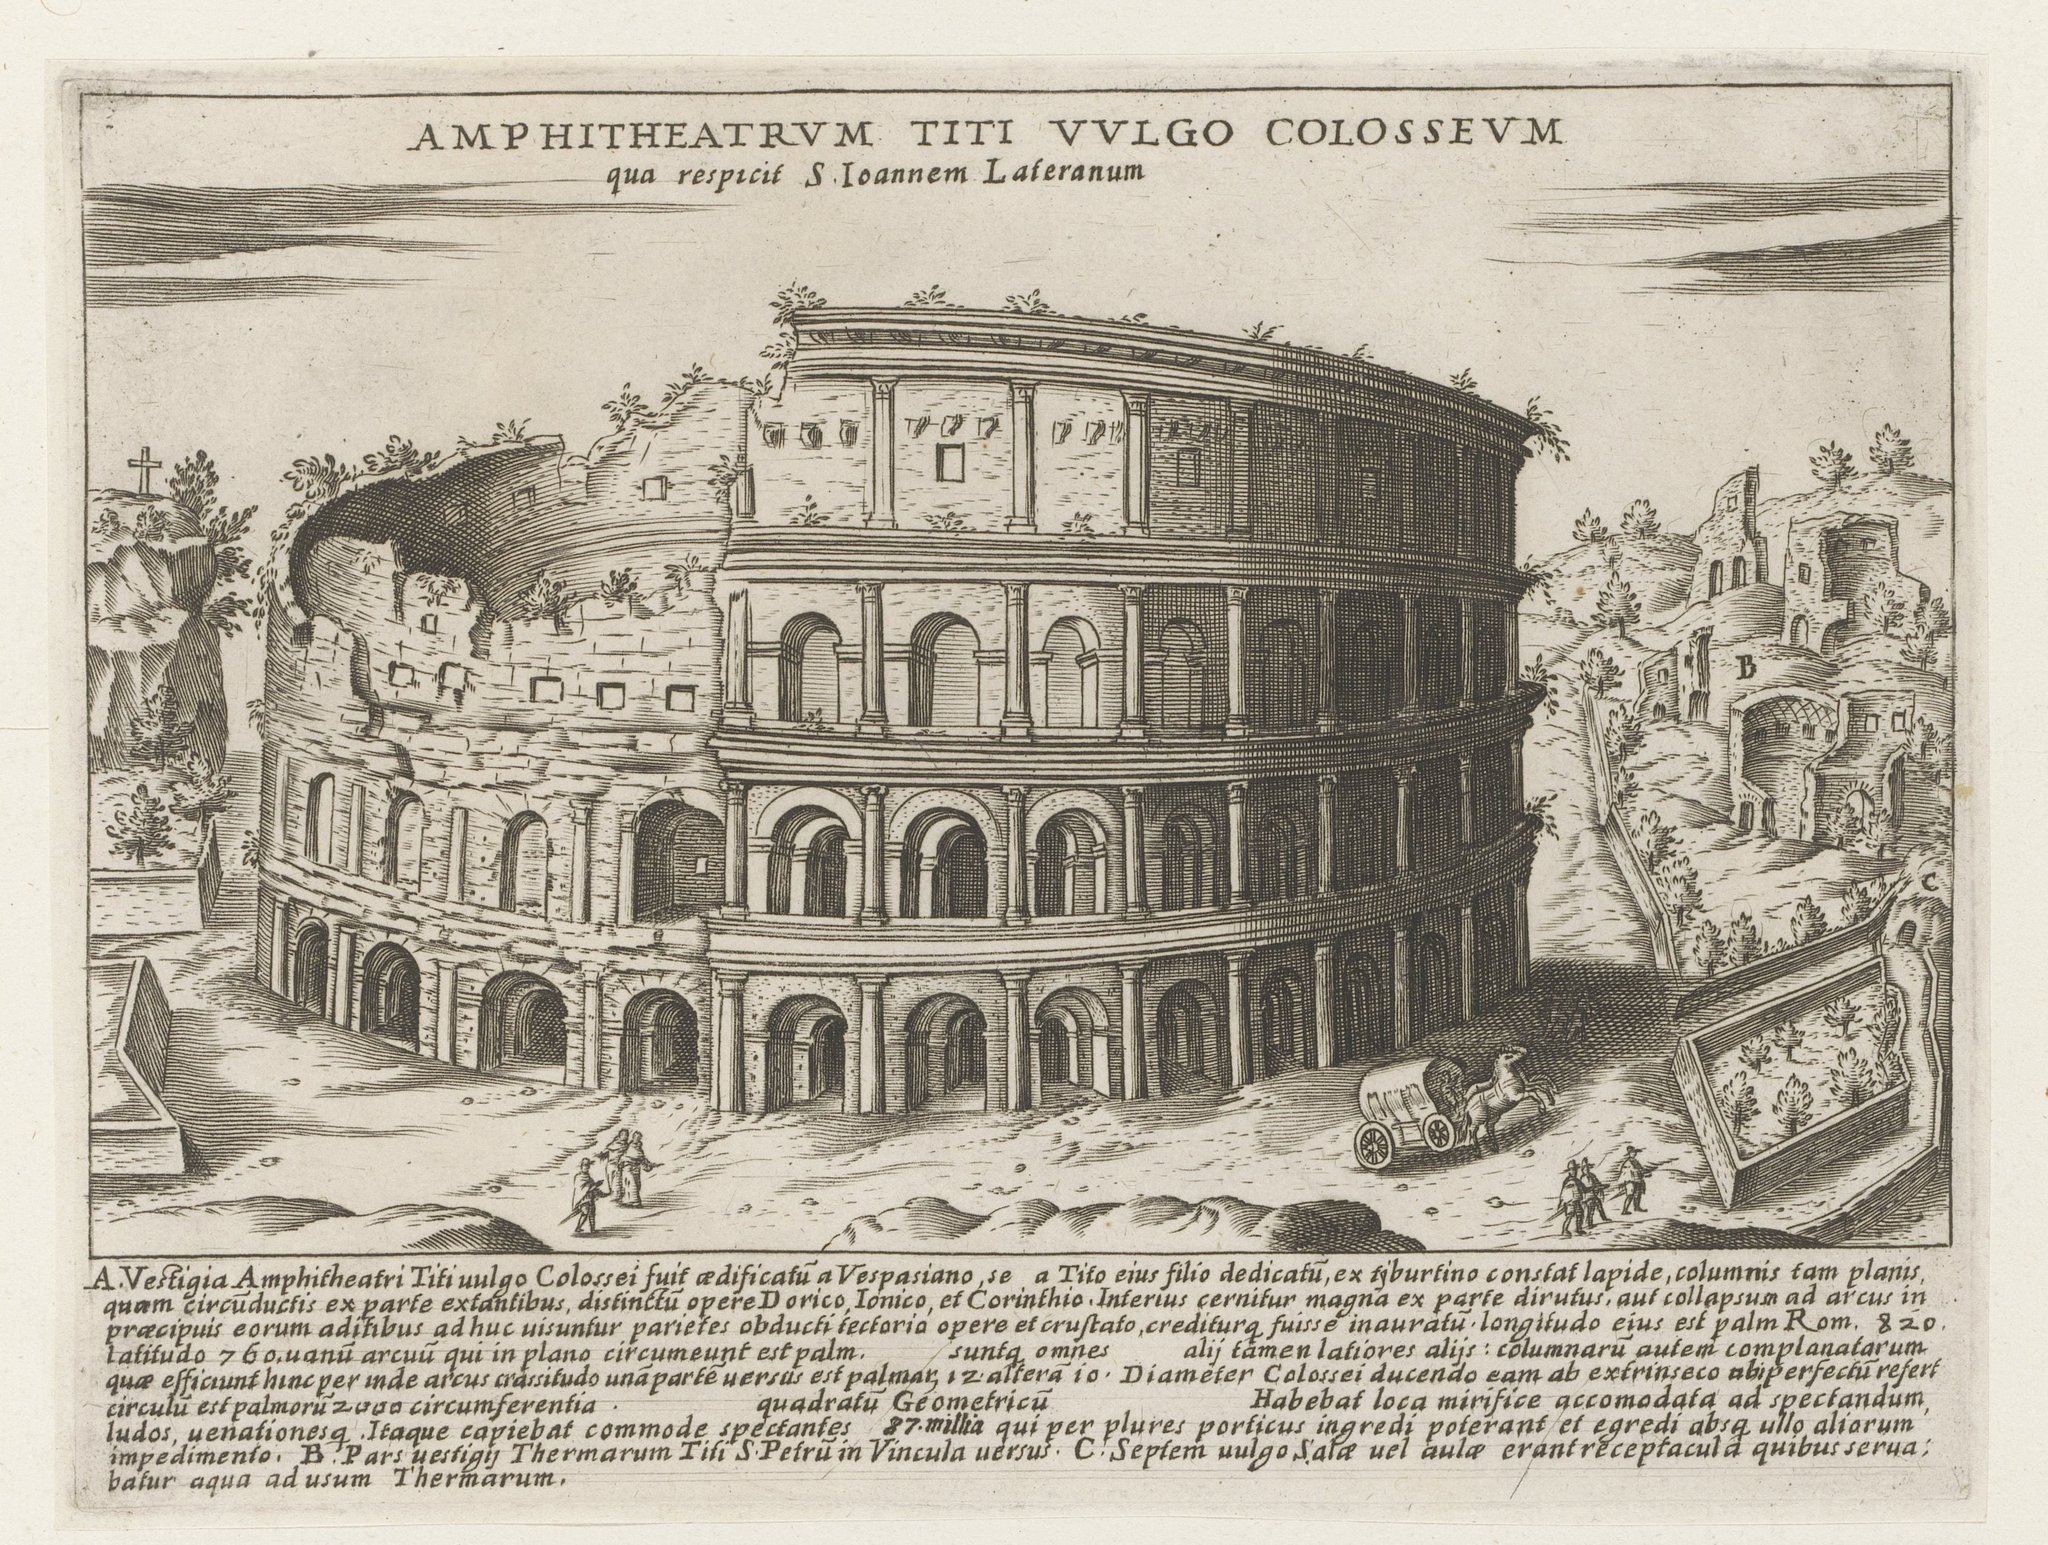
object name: album leaf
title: Antiquae Urbis Splendor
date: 1612-1628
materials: paper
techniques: etching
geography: rome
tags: theatre (building) - aa - open-air performances, representation of real building (either existing or having existed)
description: Deze prent maakt deel uit van een set van 158 prenten (+ titelprenten), die verscheen in vier delen. In 1612 verschenen delen één en twee. In 1615 verscheen het derde deel en in 1628 verscheen deel vier. In 1637 publiceerde Vitale Mascardi de eerste heruitgave van de gehele set met nummering.